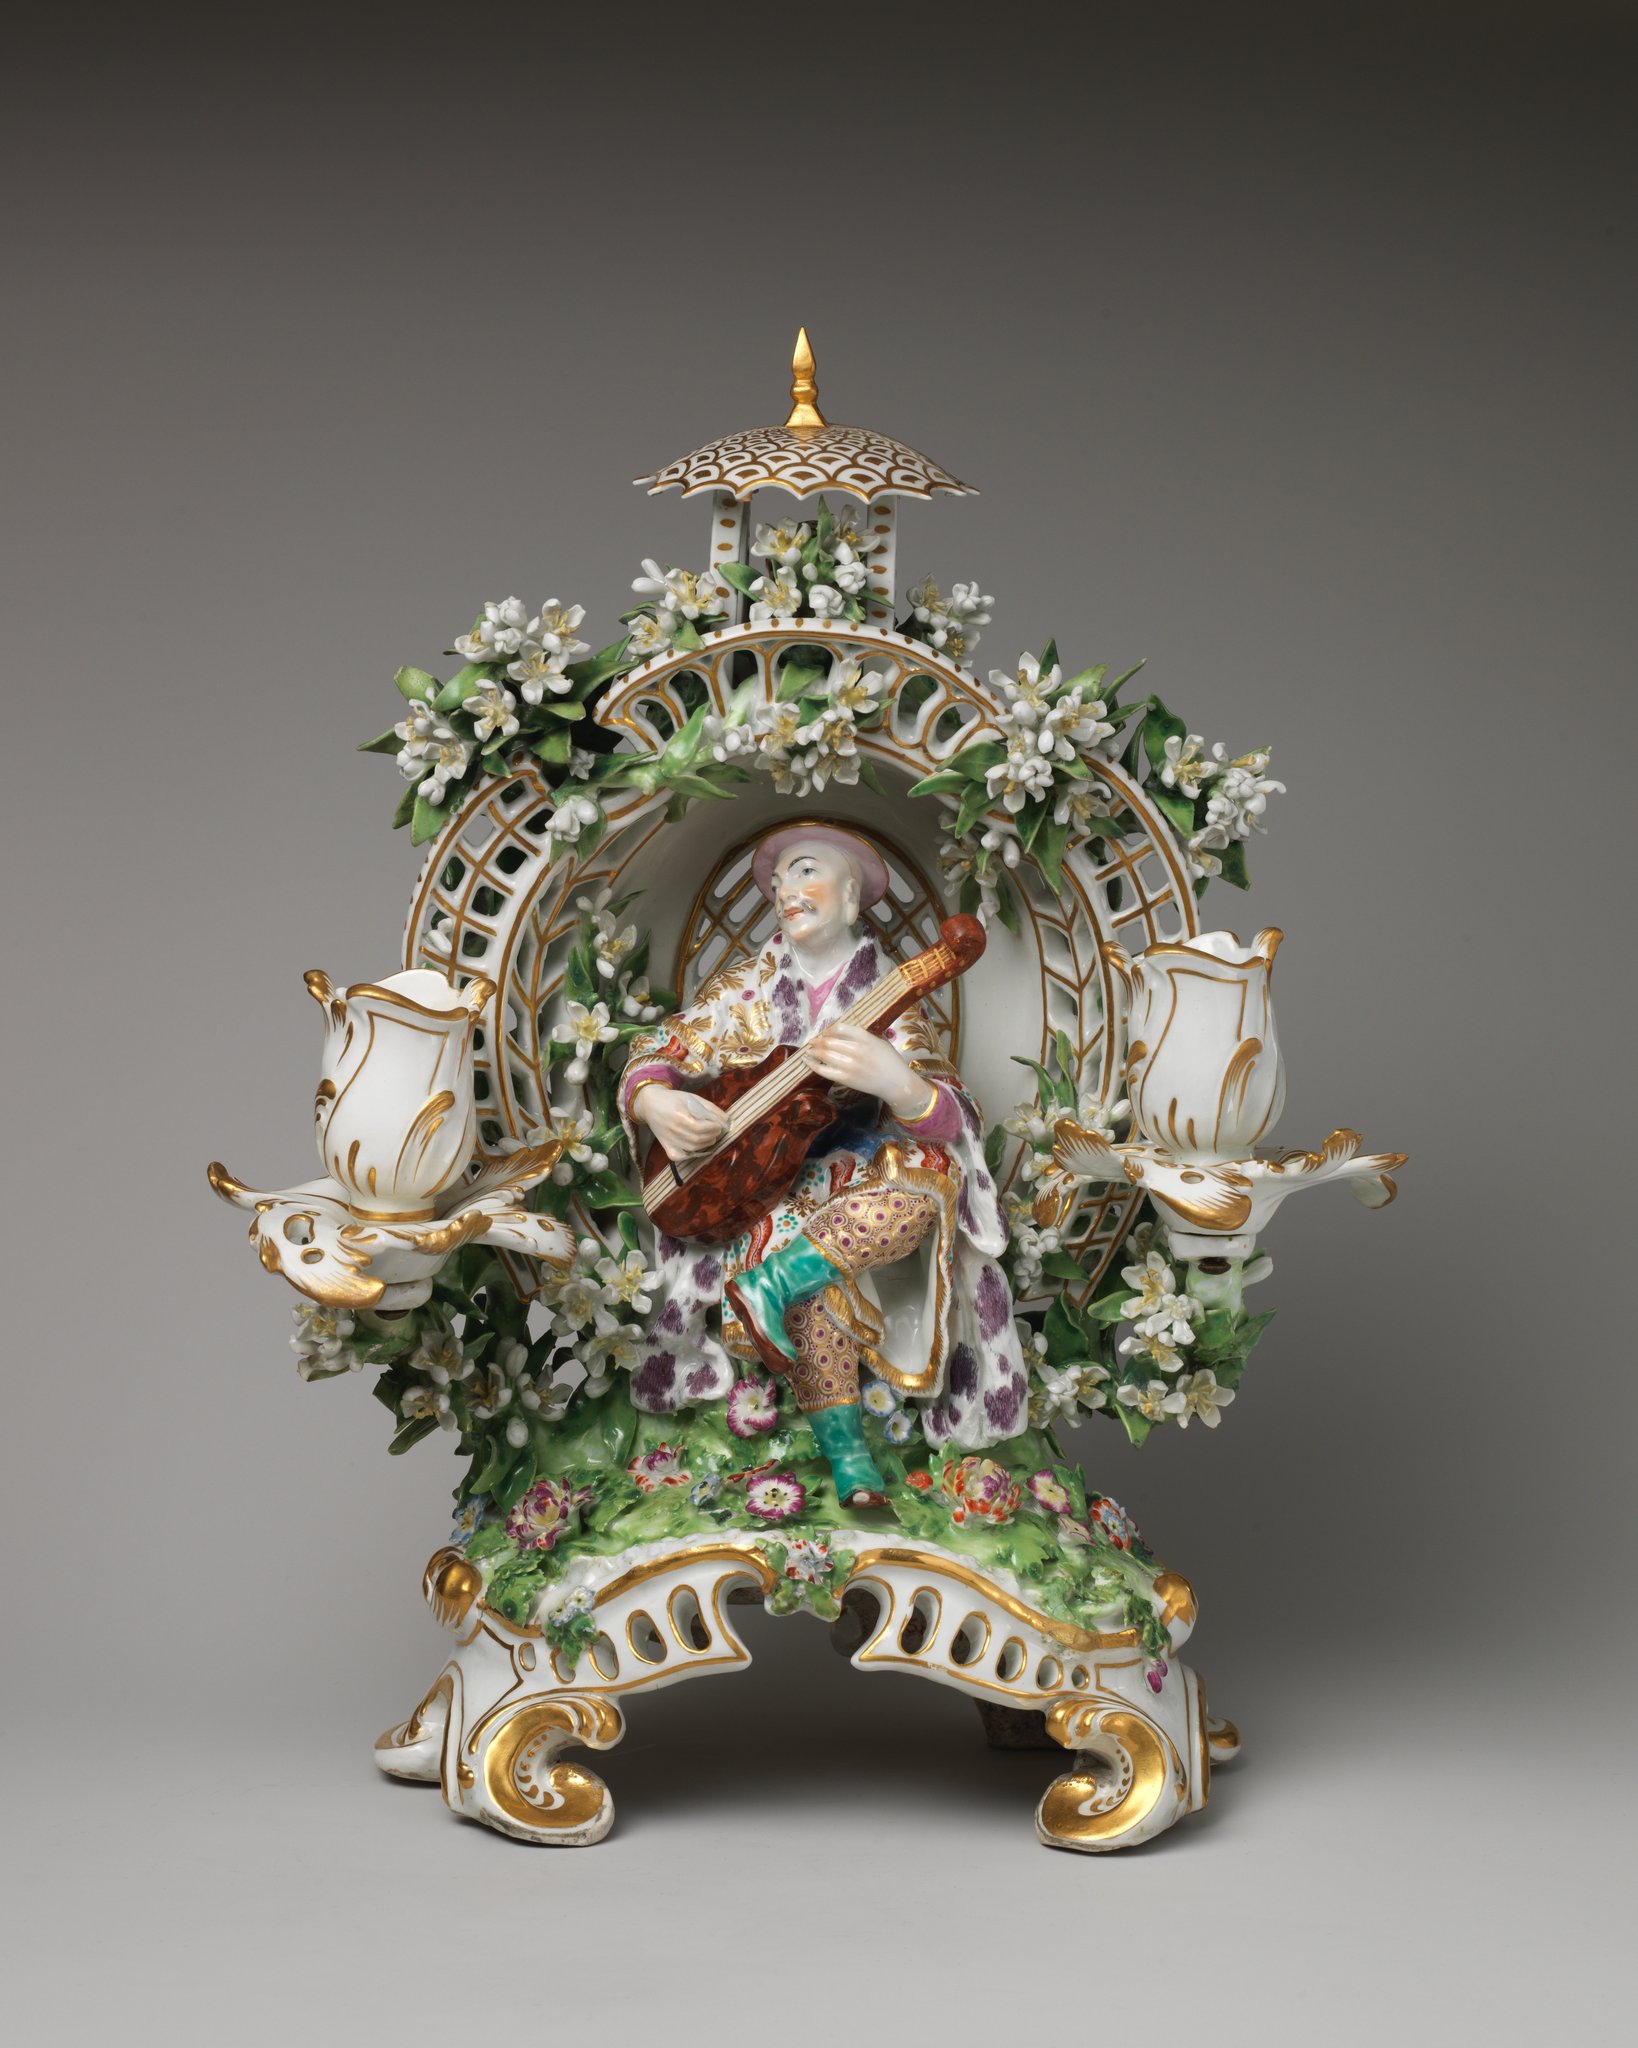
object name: candelabrum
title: Candelabrum (one of a pair)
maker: chelsea porcelain manufactory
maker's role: factory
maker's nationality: british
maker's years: 1744-1784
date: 1765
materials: soft paste porcelain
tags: chinoiserie,men,guitars,musicians